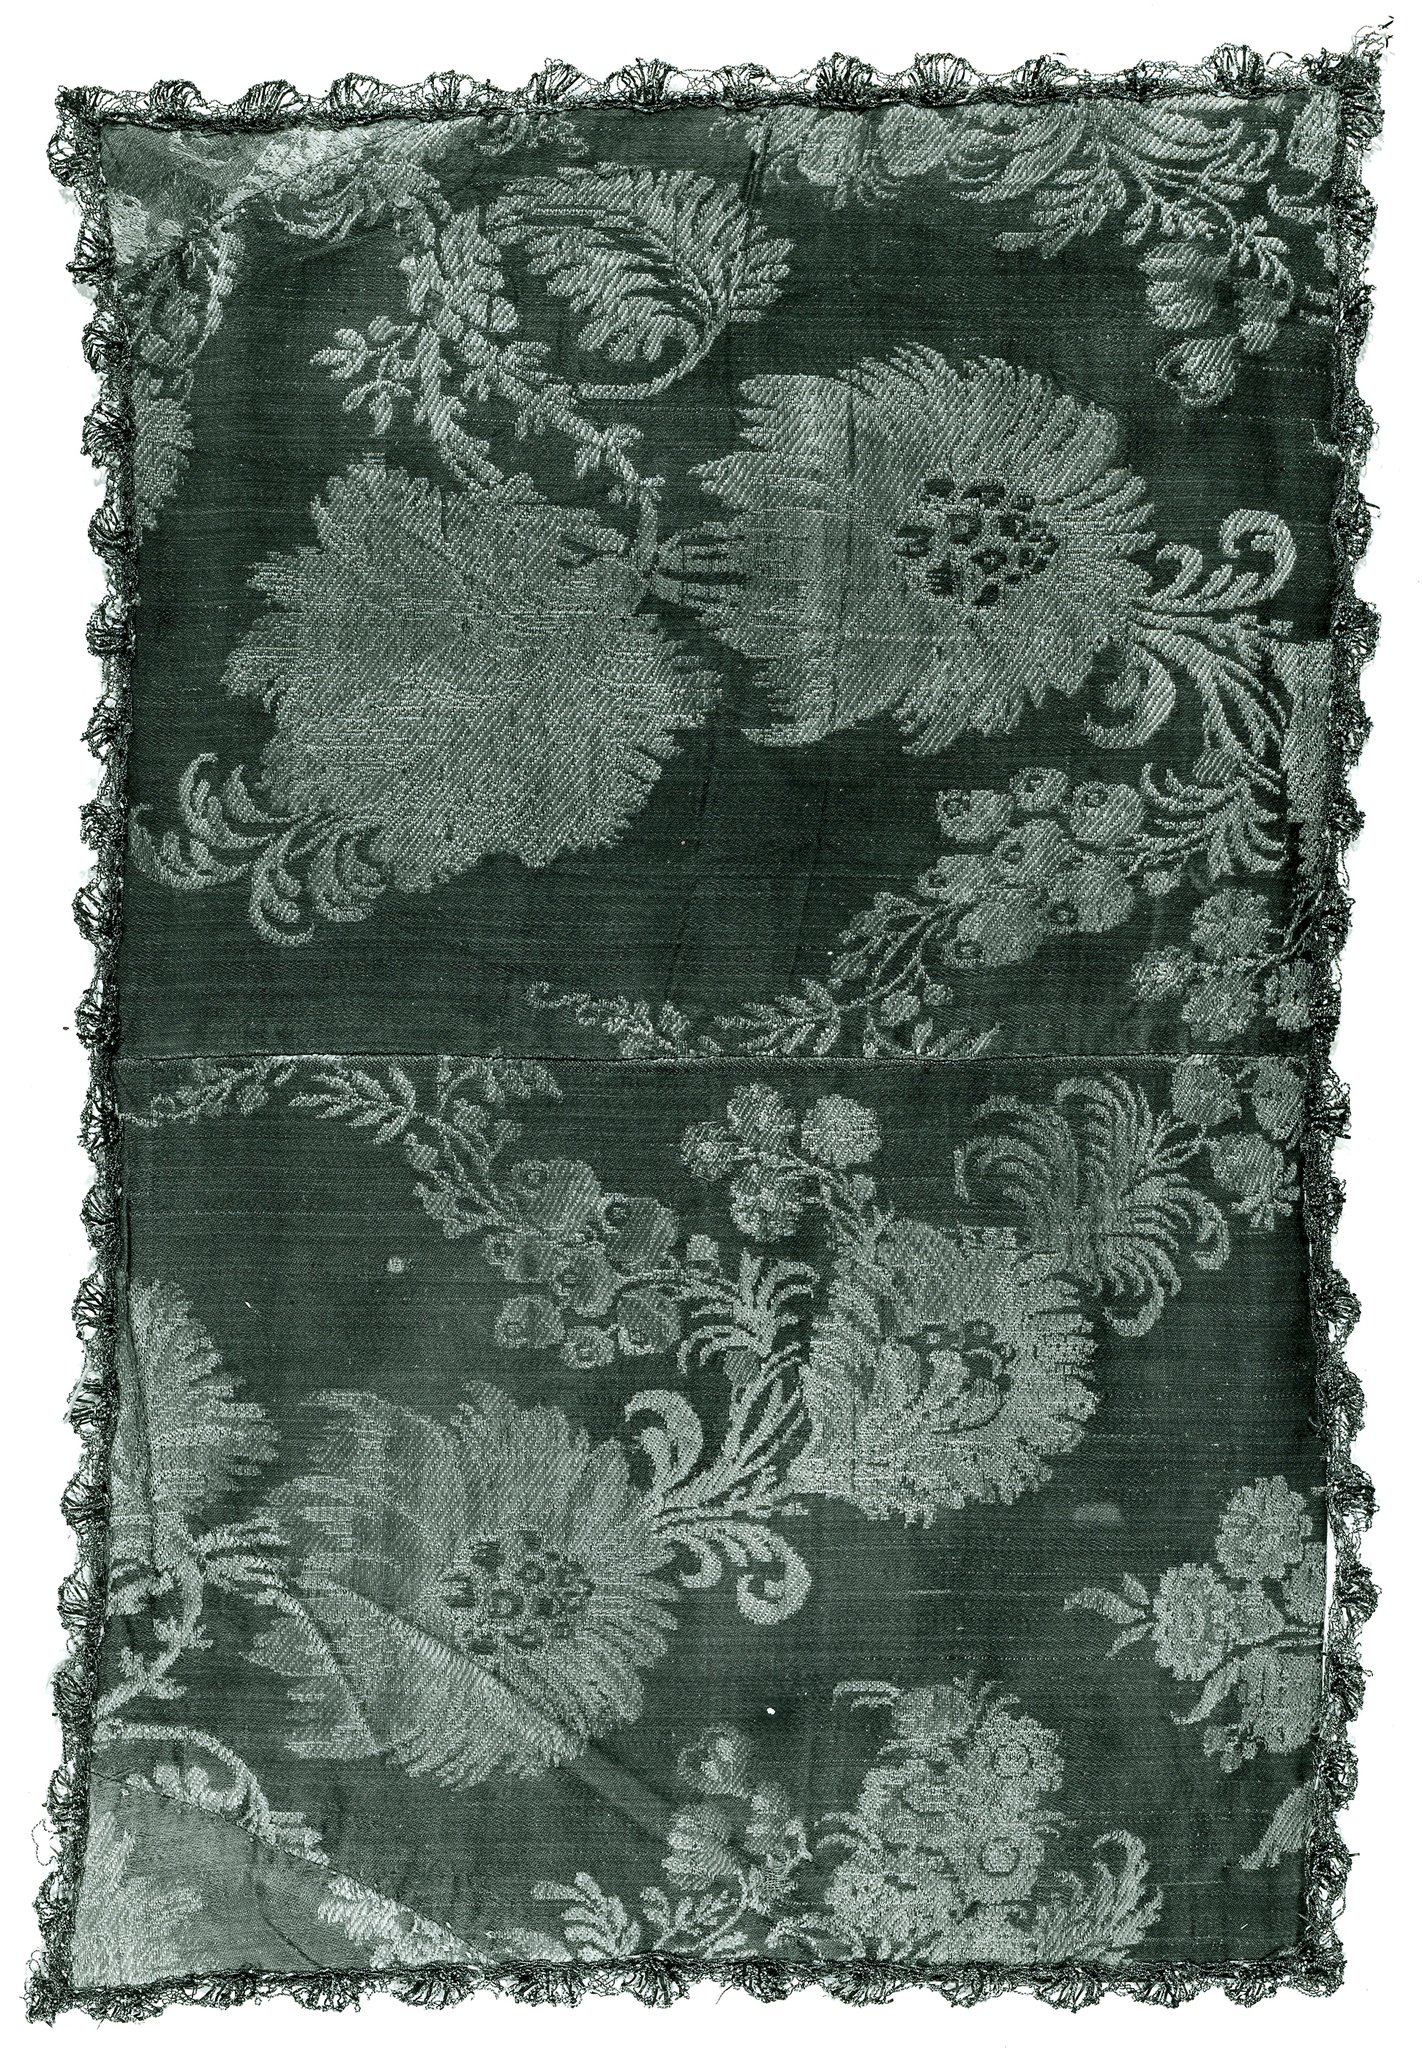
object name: textile fragment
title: Fragment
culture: french or italian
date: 1701-1800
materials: cotton, metal, silk